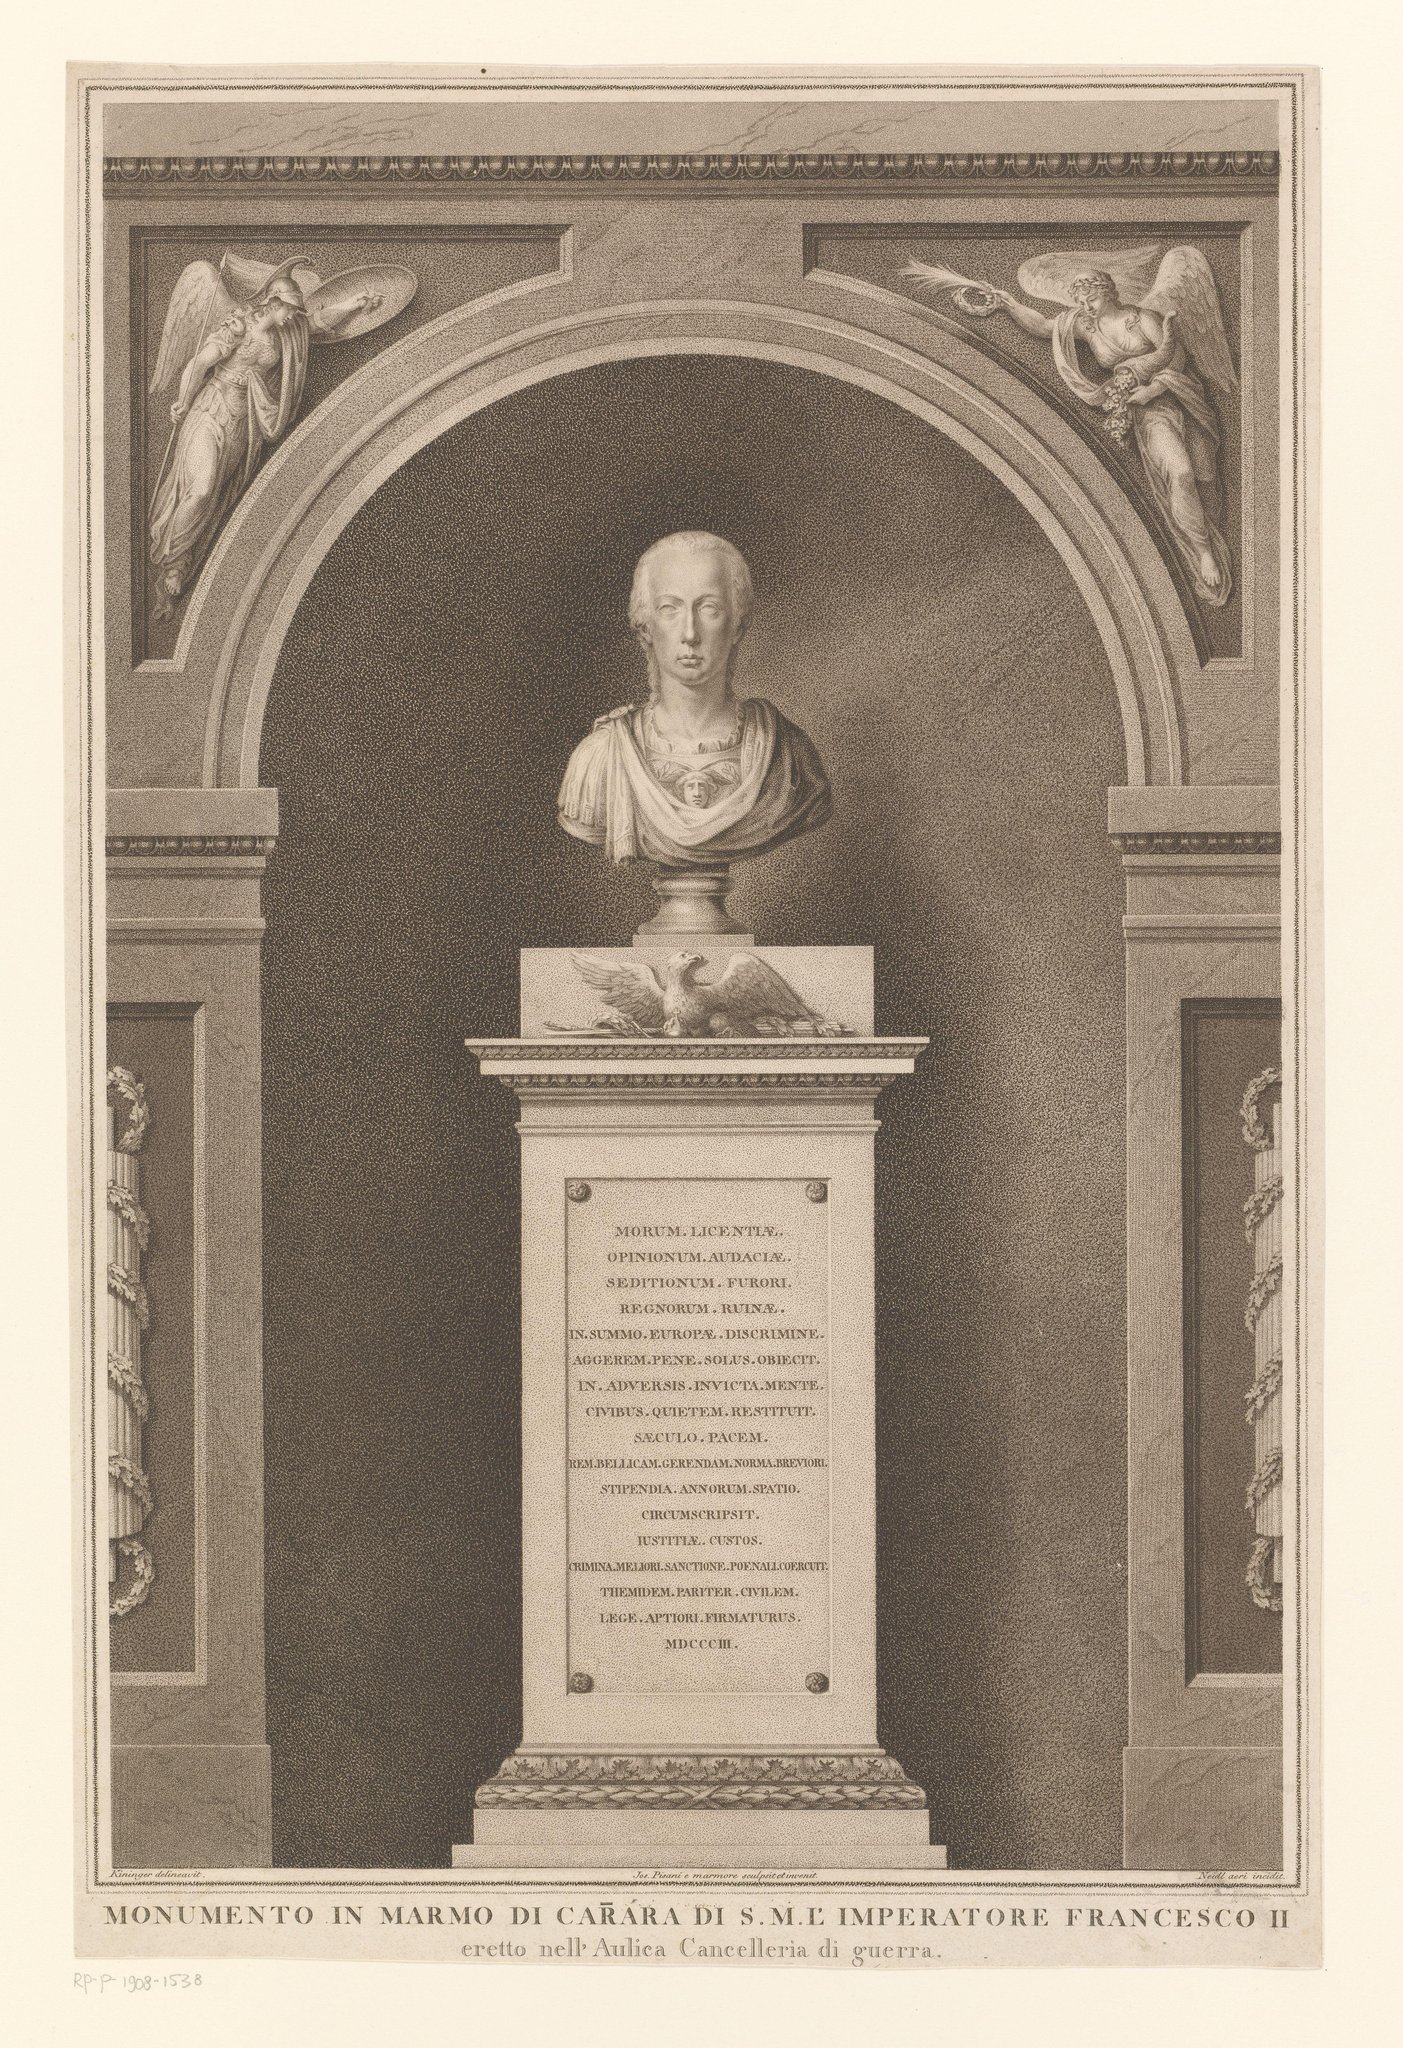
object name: print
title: Monument van keizer Frans II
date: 1803-1832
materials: paper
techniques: stippling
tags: vienna, frans ii (rooms-duits keizer), monument, statue, ruler, sovereign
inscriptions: collector's mark: Lugt 2228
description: Tekst in het Italiaans in de ondermarge en tekst in het Latijn op de sokkel.